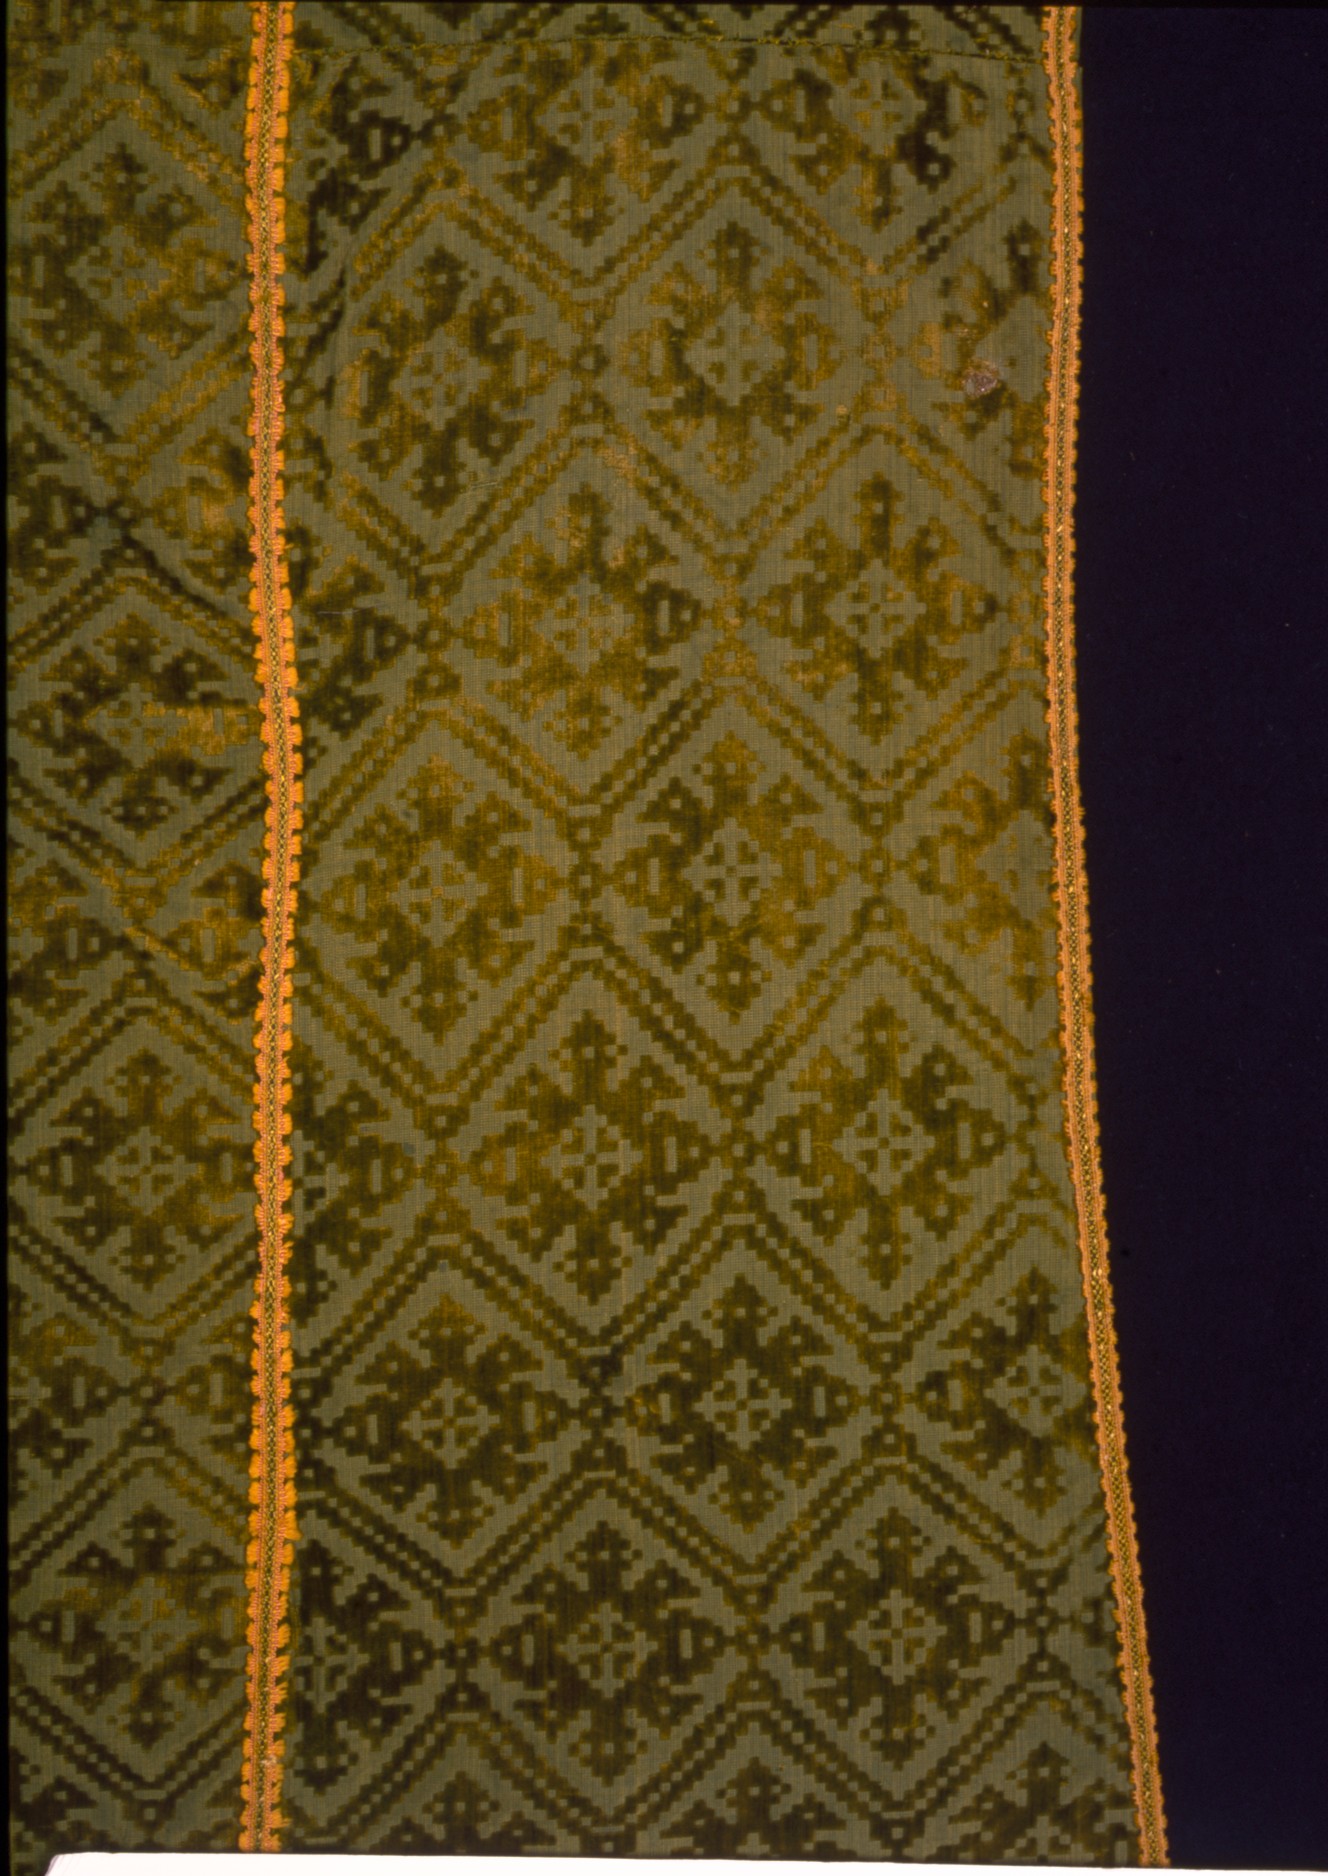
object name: chasuble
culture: italian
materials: linen, silk